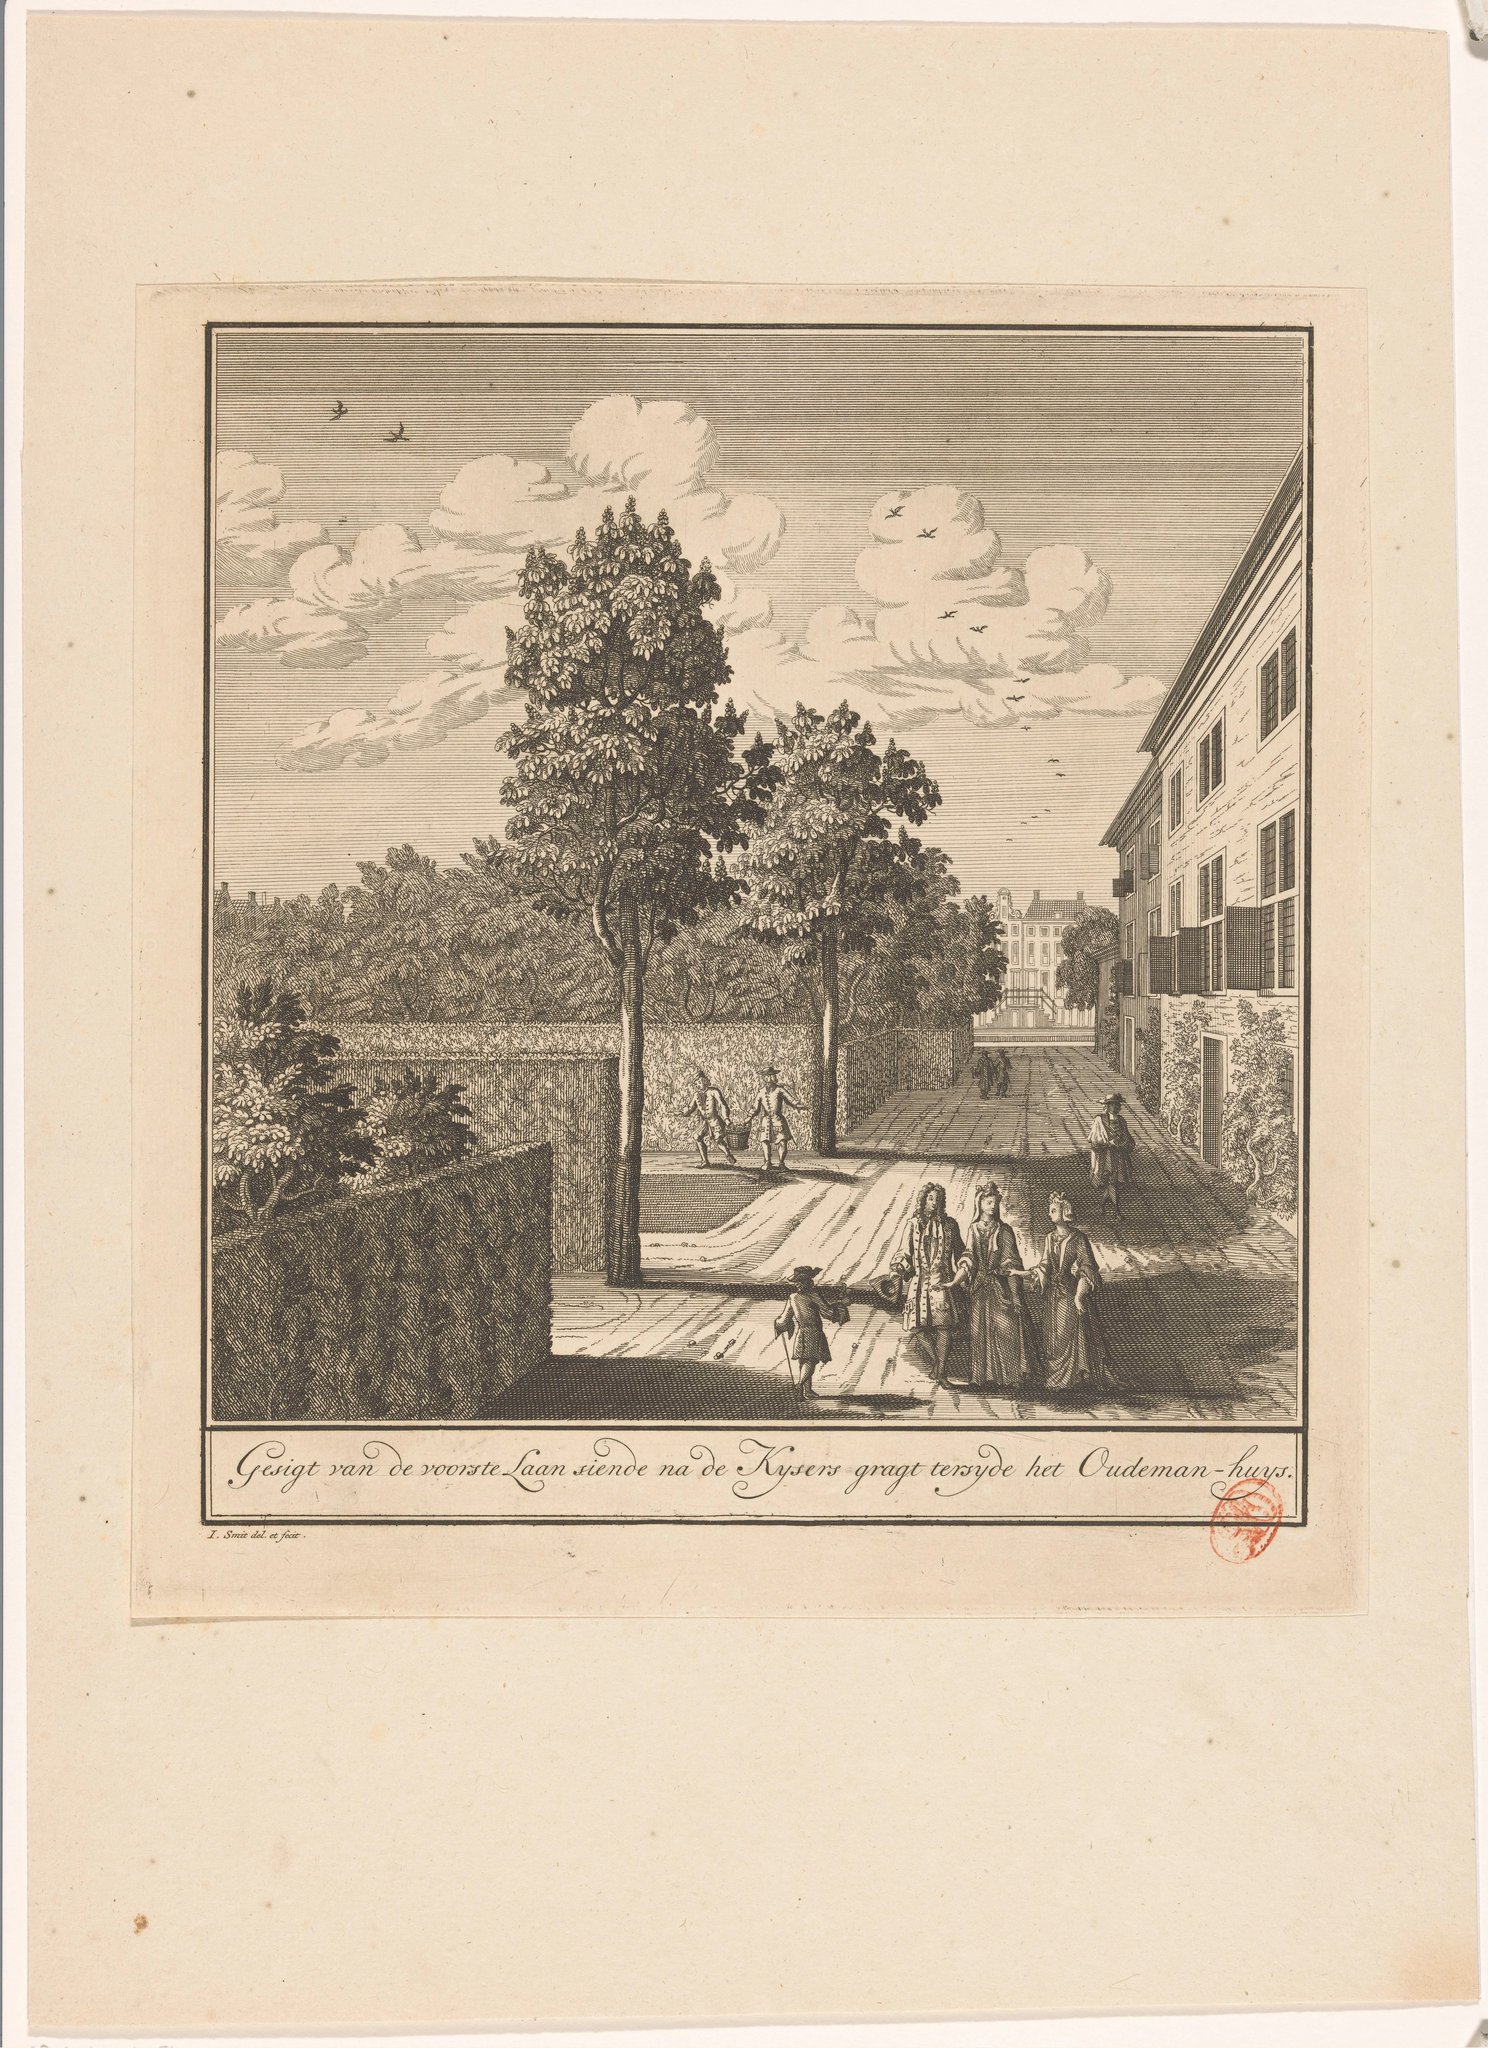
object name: print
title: Gesigt van de voorste Laan siende na de Kysers gragt tersyde het Oudeman-huys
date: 1723-1748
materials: paper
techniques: engraving, etching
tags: alms-house (dutch: 'hofje'), public welfare, french or architectonic garden; formal garden, gardening, old-people's home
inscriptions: collector's mark: Lugt 195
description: Gezicht op een deel van de tuin van het Corvershof aan de Nieuwe Herengracht te Amsterdam, gezien richting de Nieuwe Keizersgracht. Rechts een deel van het aangrenzende Diaconie Oude Vrouwen- en Mannenhuis. Op de laan wandelen verschillende figuren. In het midden twee tuinmannen met een mand. Onderdeel van een serie prenten van het in 1723 in gebruik genomen Corvershof, bestemd voor oudere echtparen van Nederduits Gereformeerde (later Hervormde) huize.